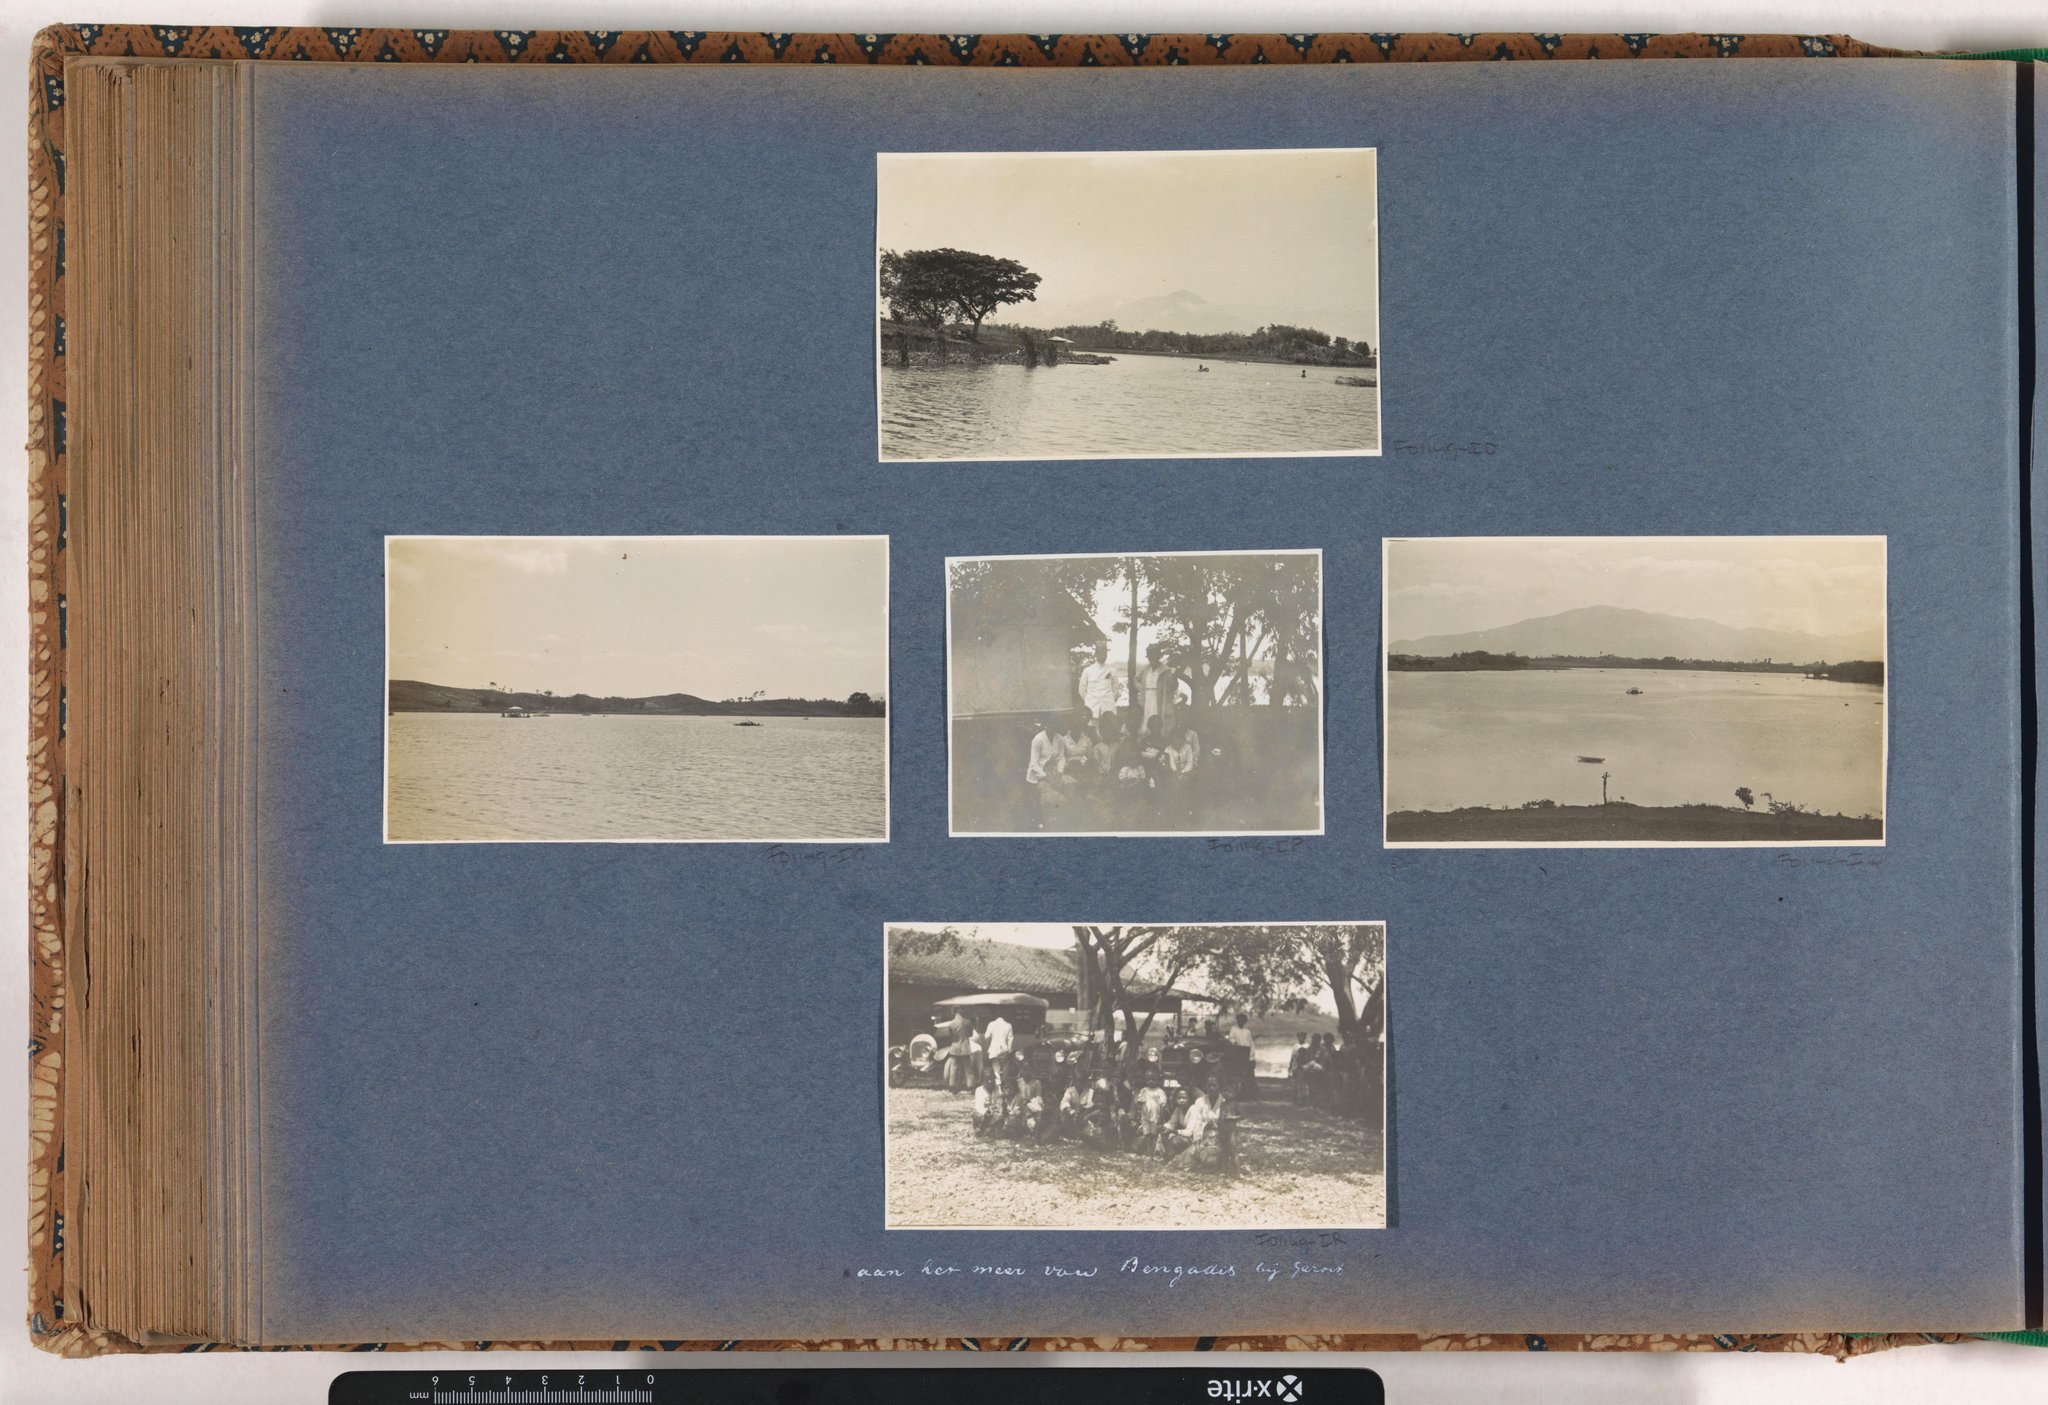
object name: album leaf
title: aan het meer van Bengadis bij Garoet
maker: Anonymous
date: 1900-1920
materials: paper, photographic support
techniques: gelatin silver print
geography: java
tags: lake, java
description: Onderdeel van reisalbum met foto's van bedrijvigheid en bezienswaardigheden op Sumatra en Java en van de reis naar en van Nederlands-Indië.